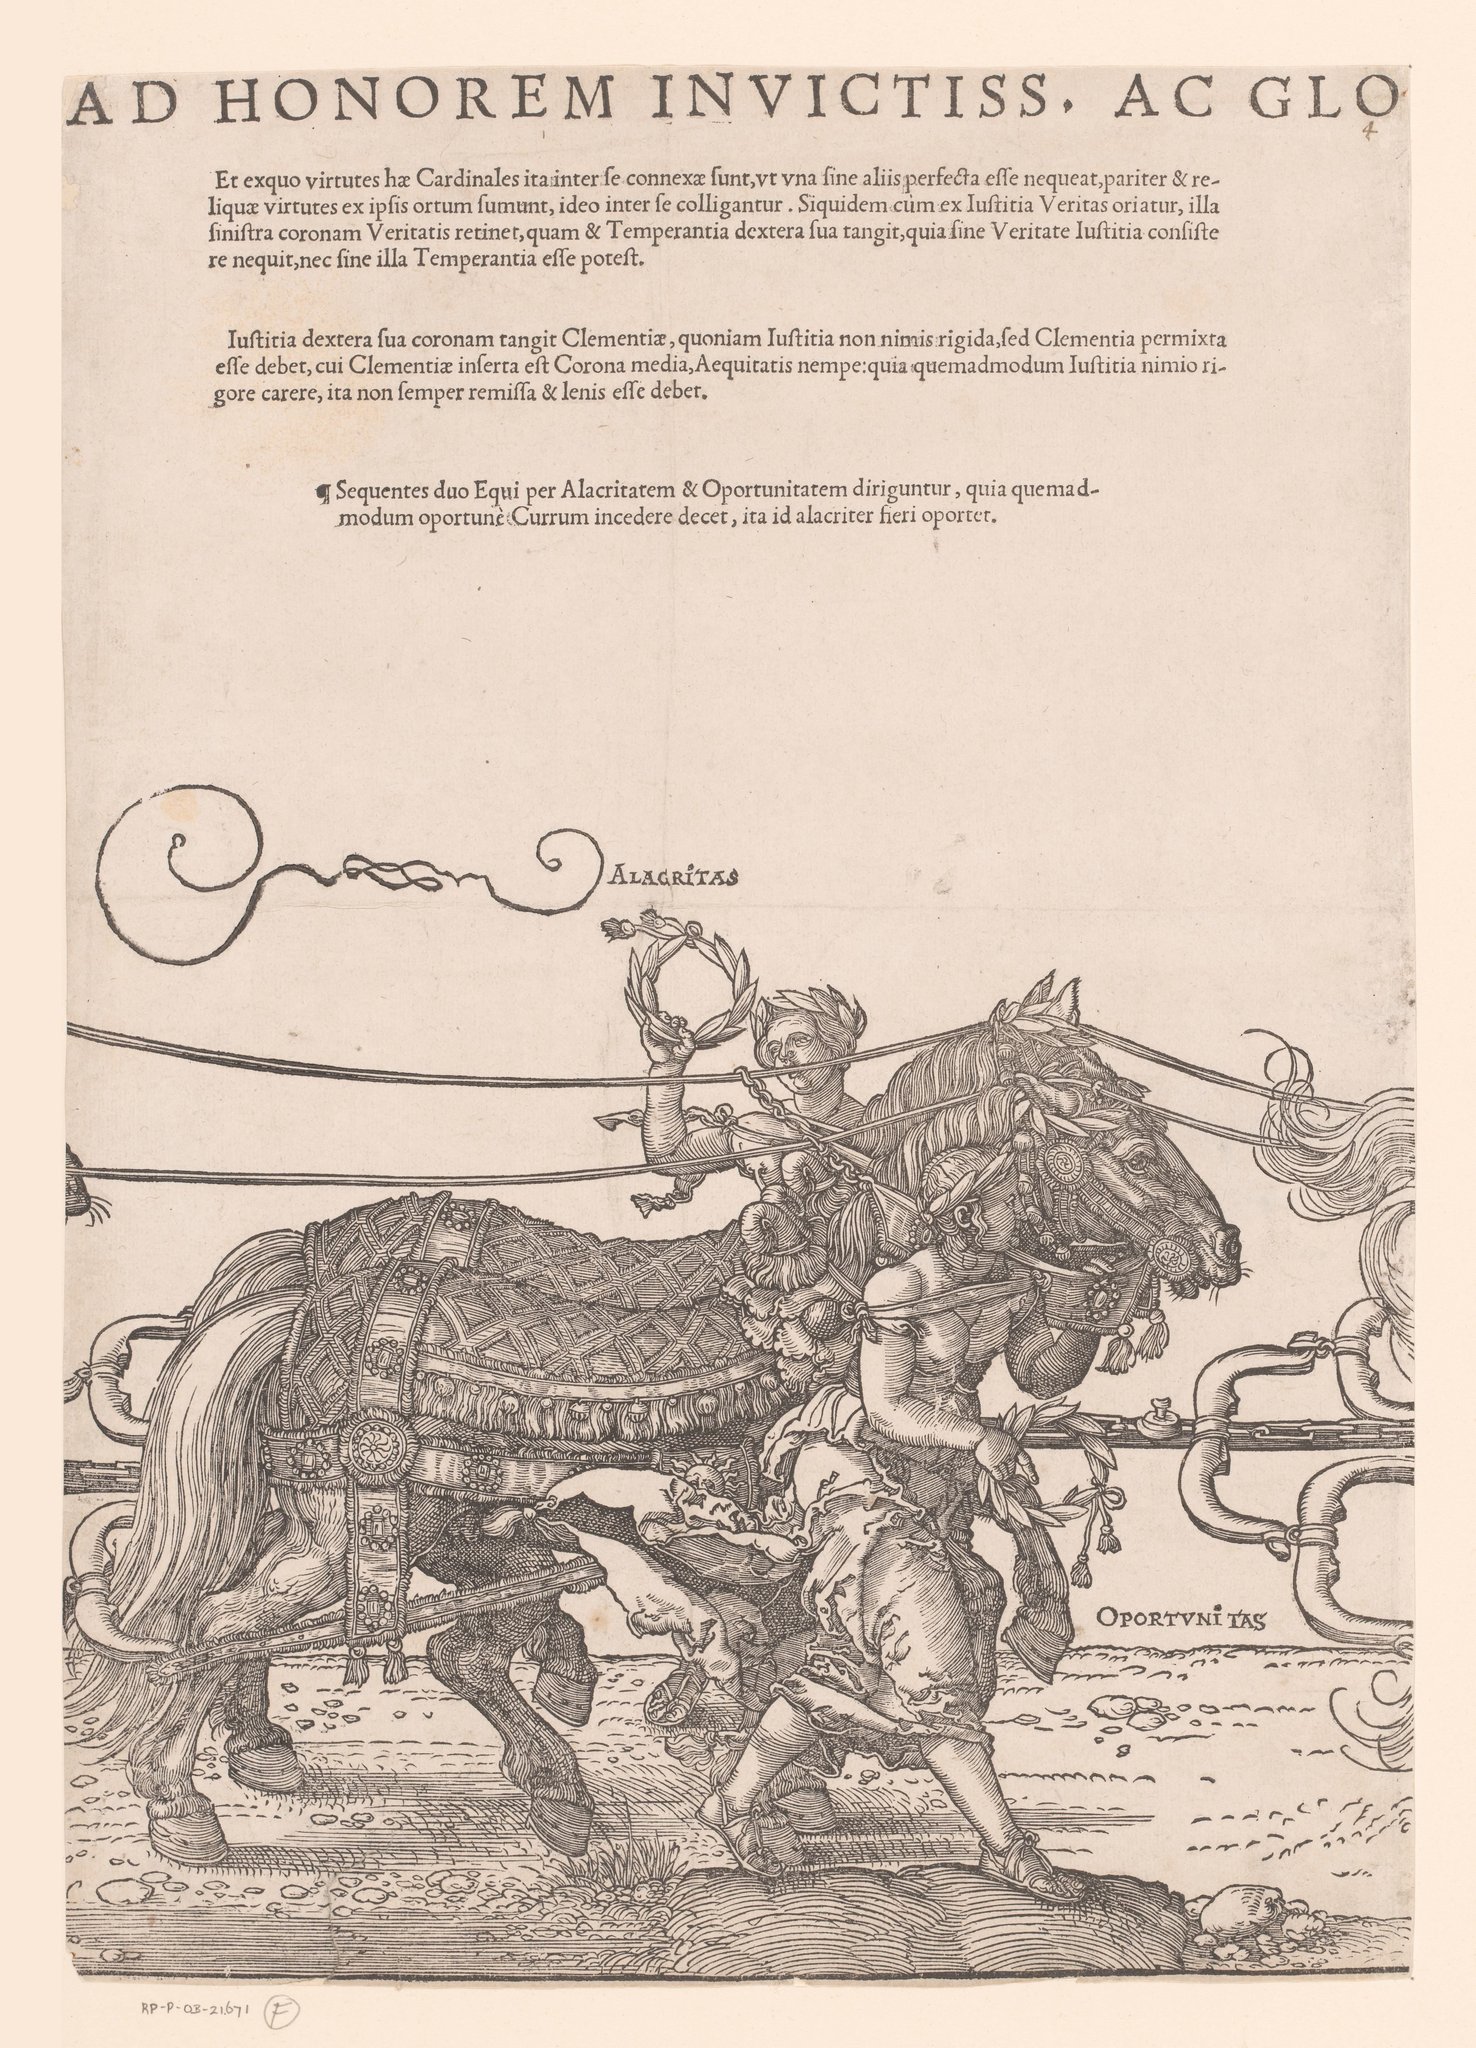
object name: print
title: Kopieën naar Dürers Triomfwagen voor keizer Maximiliaan I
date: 1522-1529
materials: paper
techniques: letterpress printing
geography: antwerp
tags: maximilian i (holy roman emperor), chariot, triumphal car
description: De grote triomfwagen ter ere van keizer Maximiliaan I bij zijn overlijden op 12 januari 1519. Vierde blad met het tweede span paarden met Alacritas en Oportunitas.